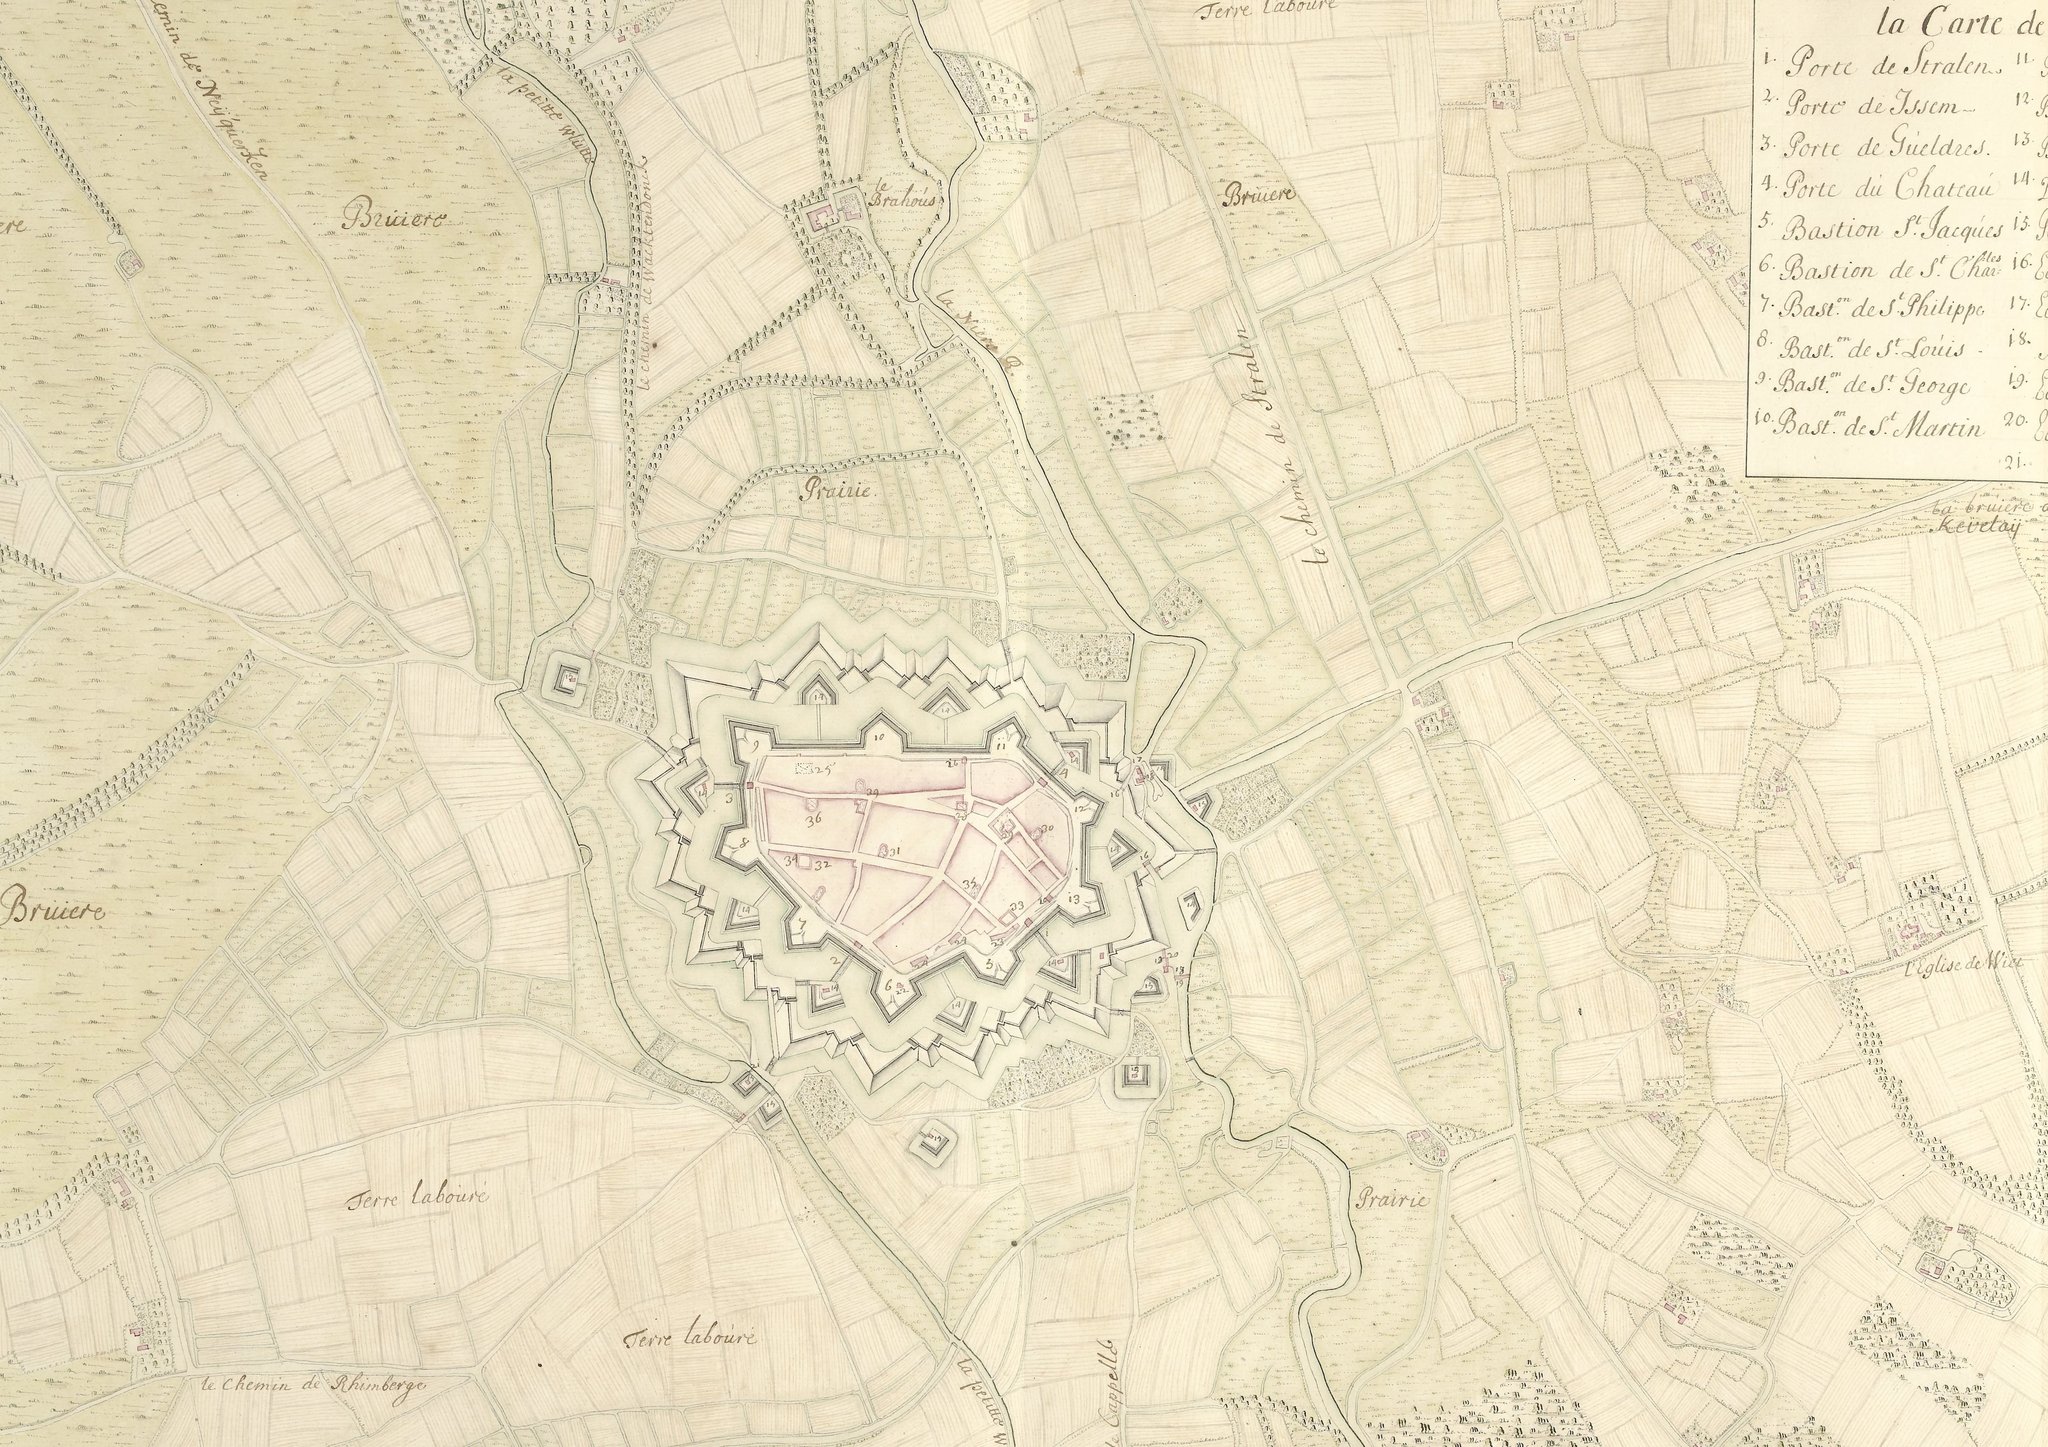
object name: map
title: Plan de la ville de Gueldre avec la Carte de ses Environs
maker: samuel du ry de champdoré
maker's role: draughtsman, engineer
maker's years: 1651-1729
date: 1701-1715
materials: paper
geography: netherlands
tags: fortress, maps of cities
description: Plattegrond van de versterkingen om de stad Geldern, met omgeving, ca. 1701-1715. Aan de rechterzijde de legenda 1-36 in het Frans. Onderdeel van een verzameling getekende plannen van versterkte plaatsen in Nederland en omringende landen ten tijde van de Spaanse Successieoorlog (deel B).